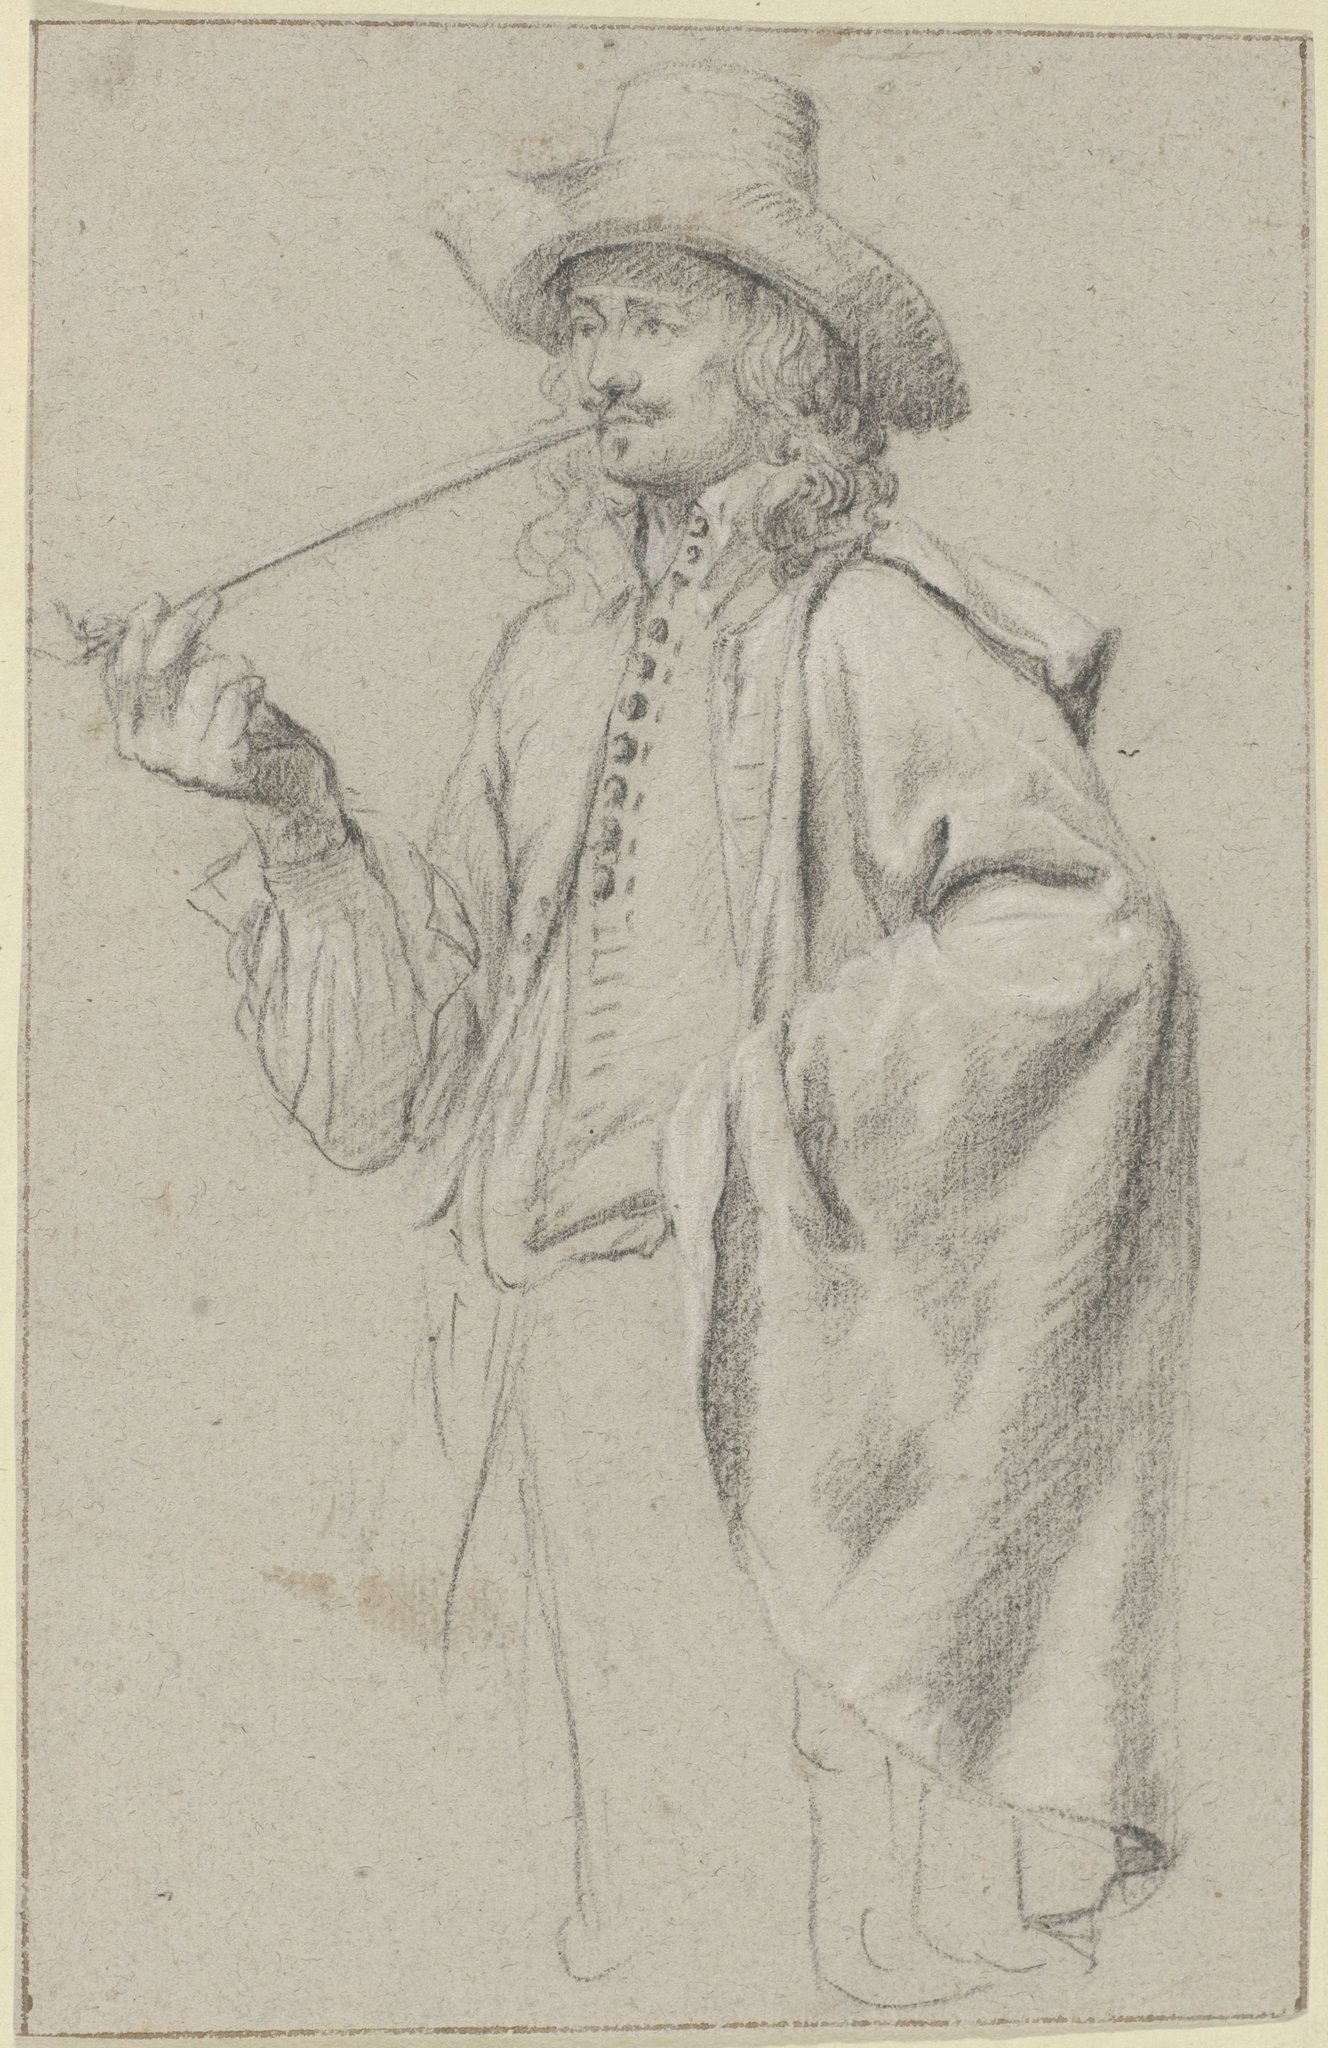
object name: drawing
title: Pijprokende man met hoed en cape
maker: Anonymous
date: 1650-1700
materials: chalk, paper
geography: netherlands